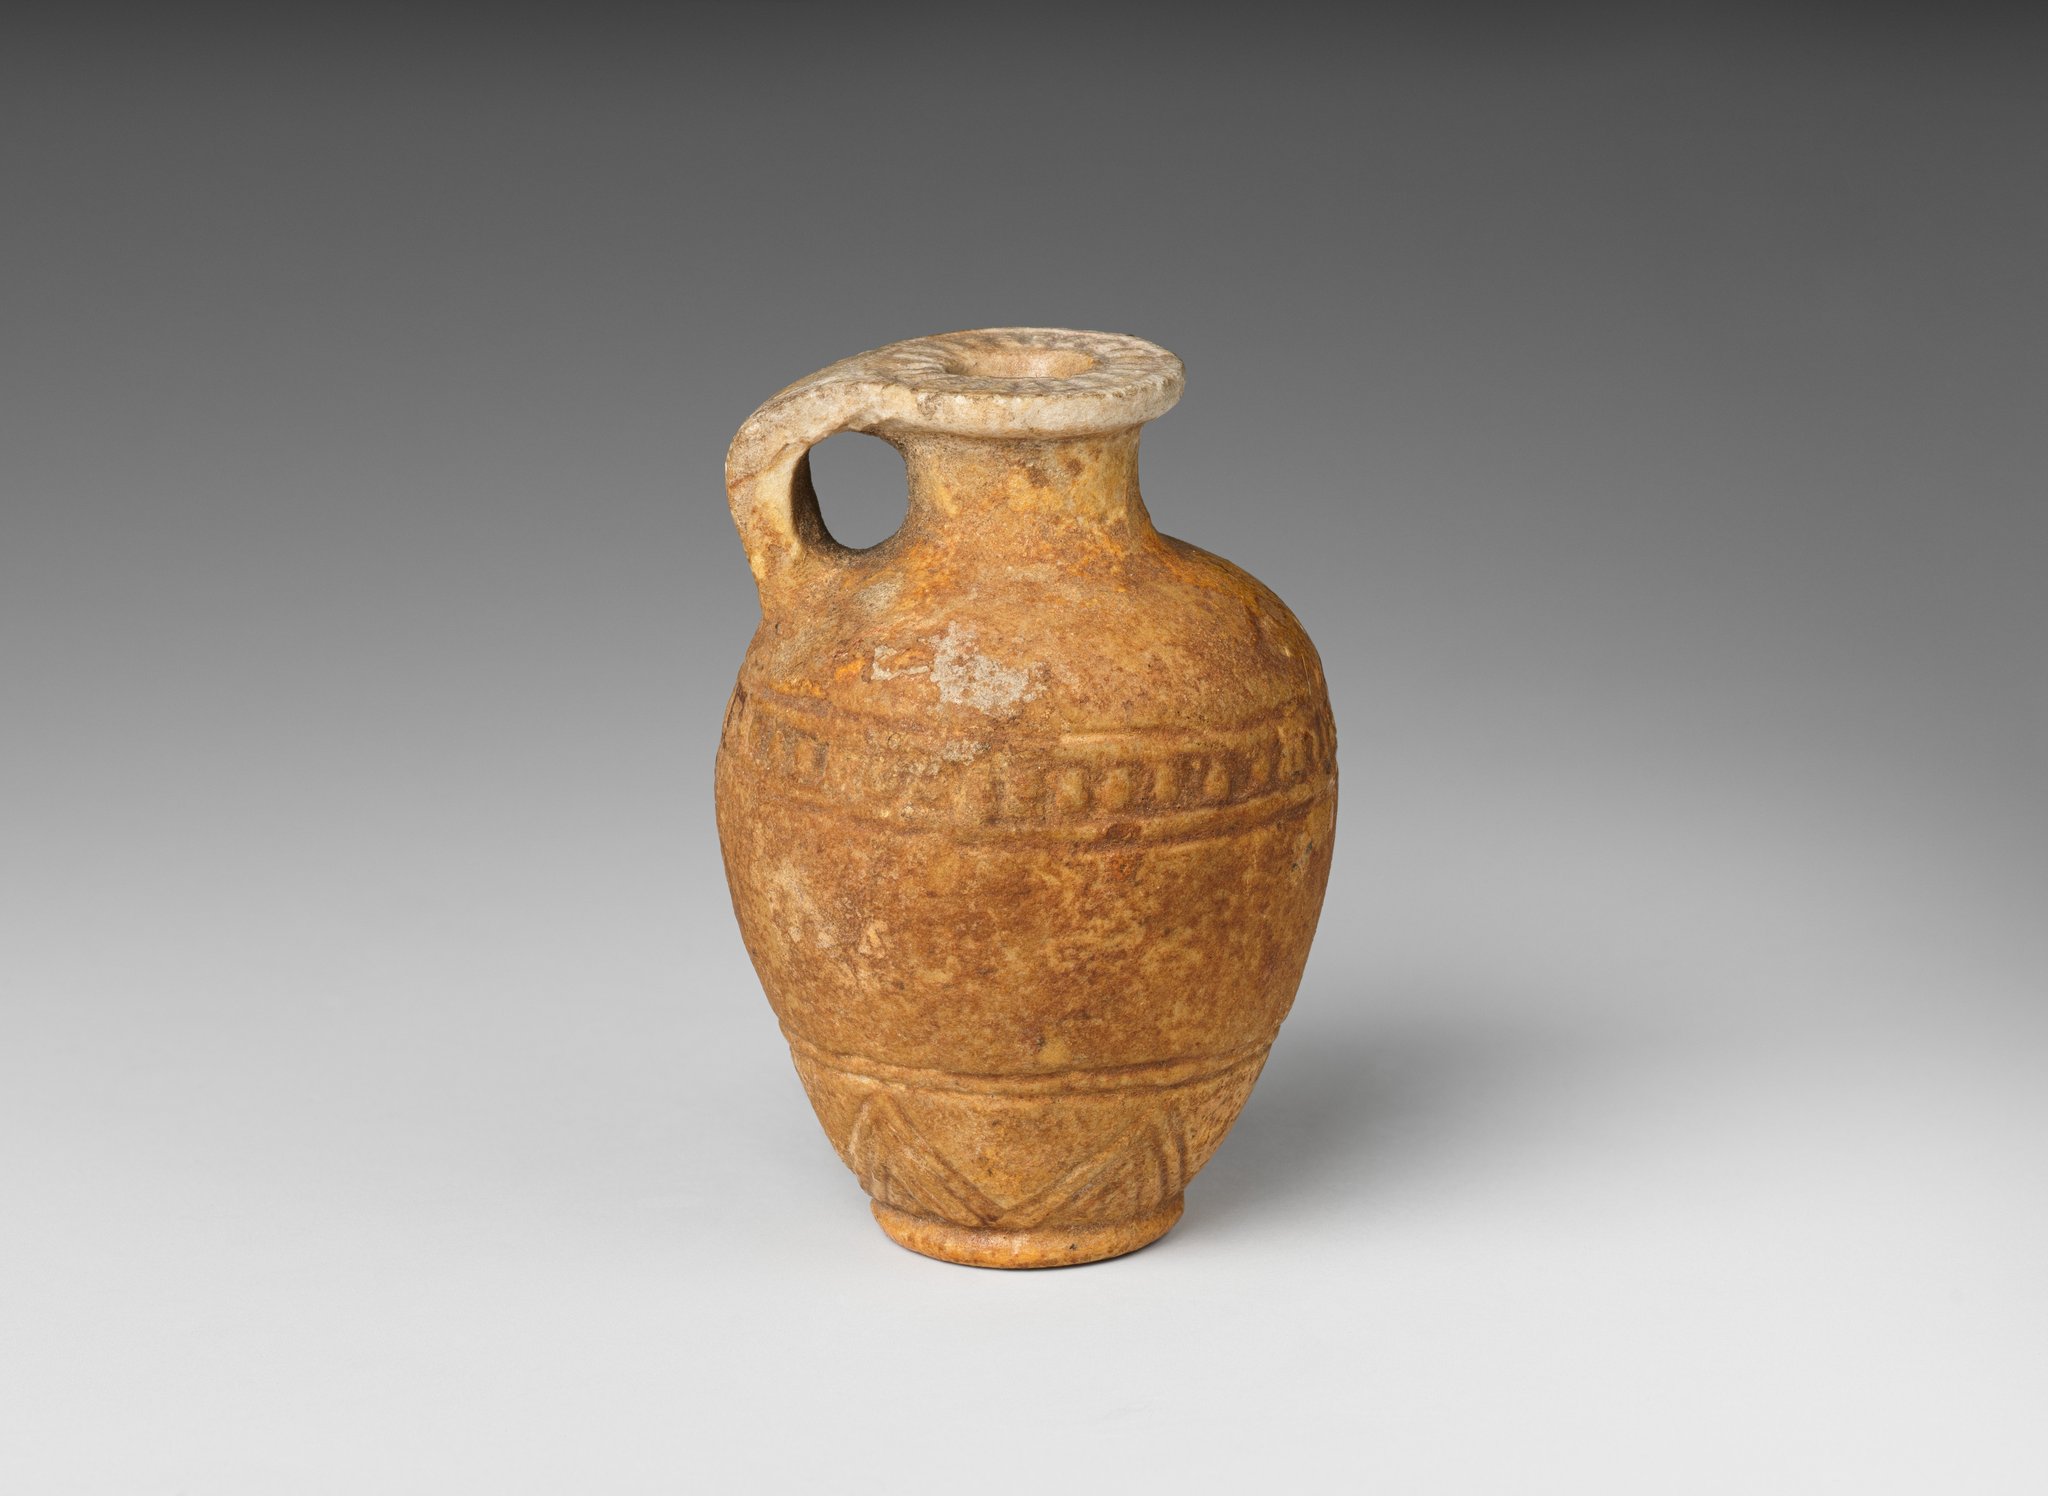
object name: jug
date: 664-332 BCE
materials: faience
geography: egypt